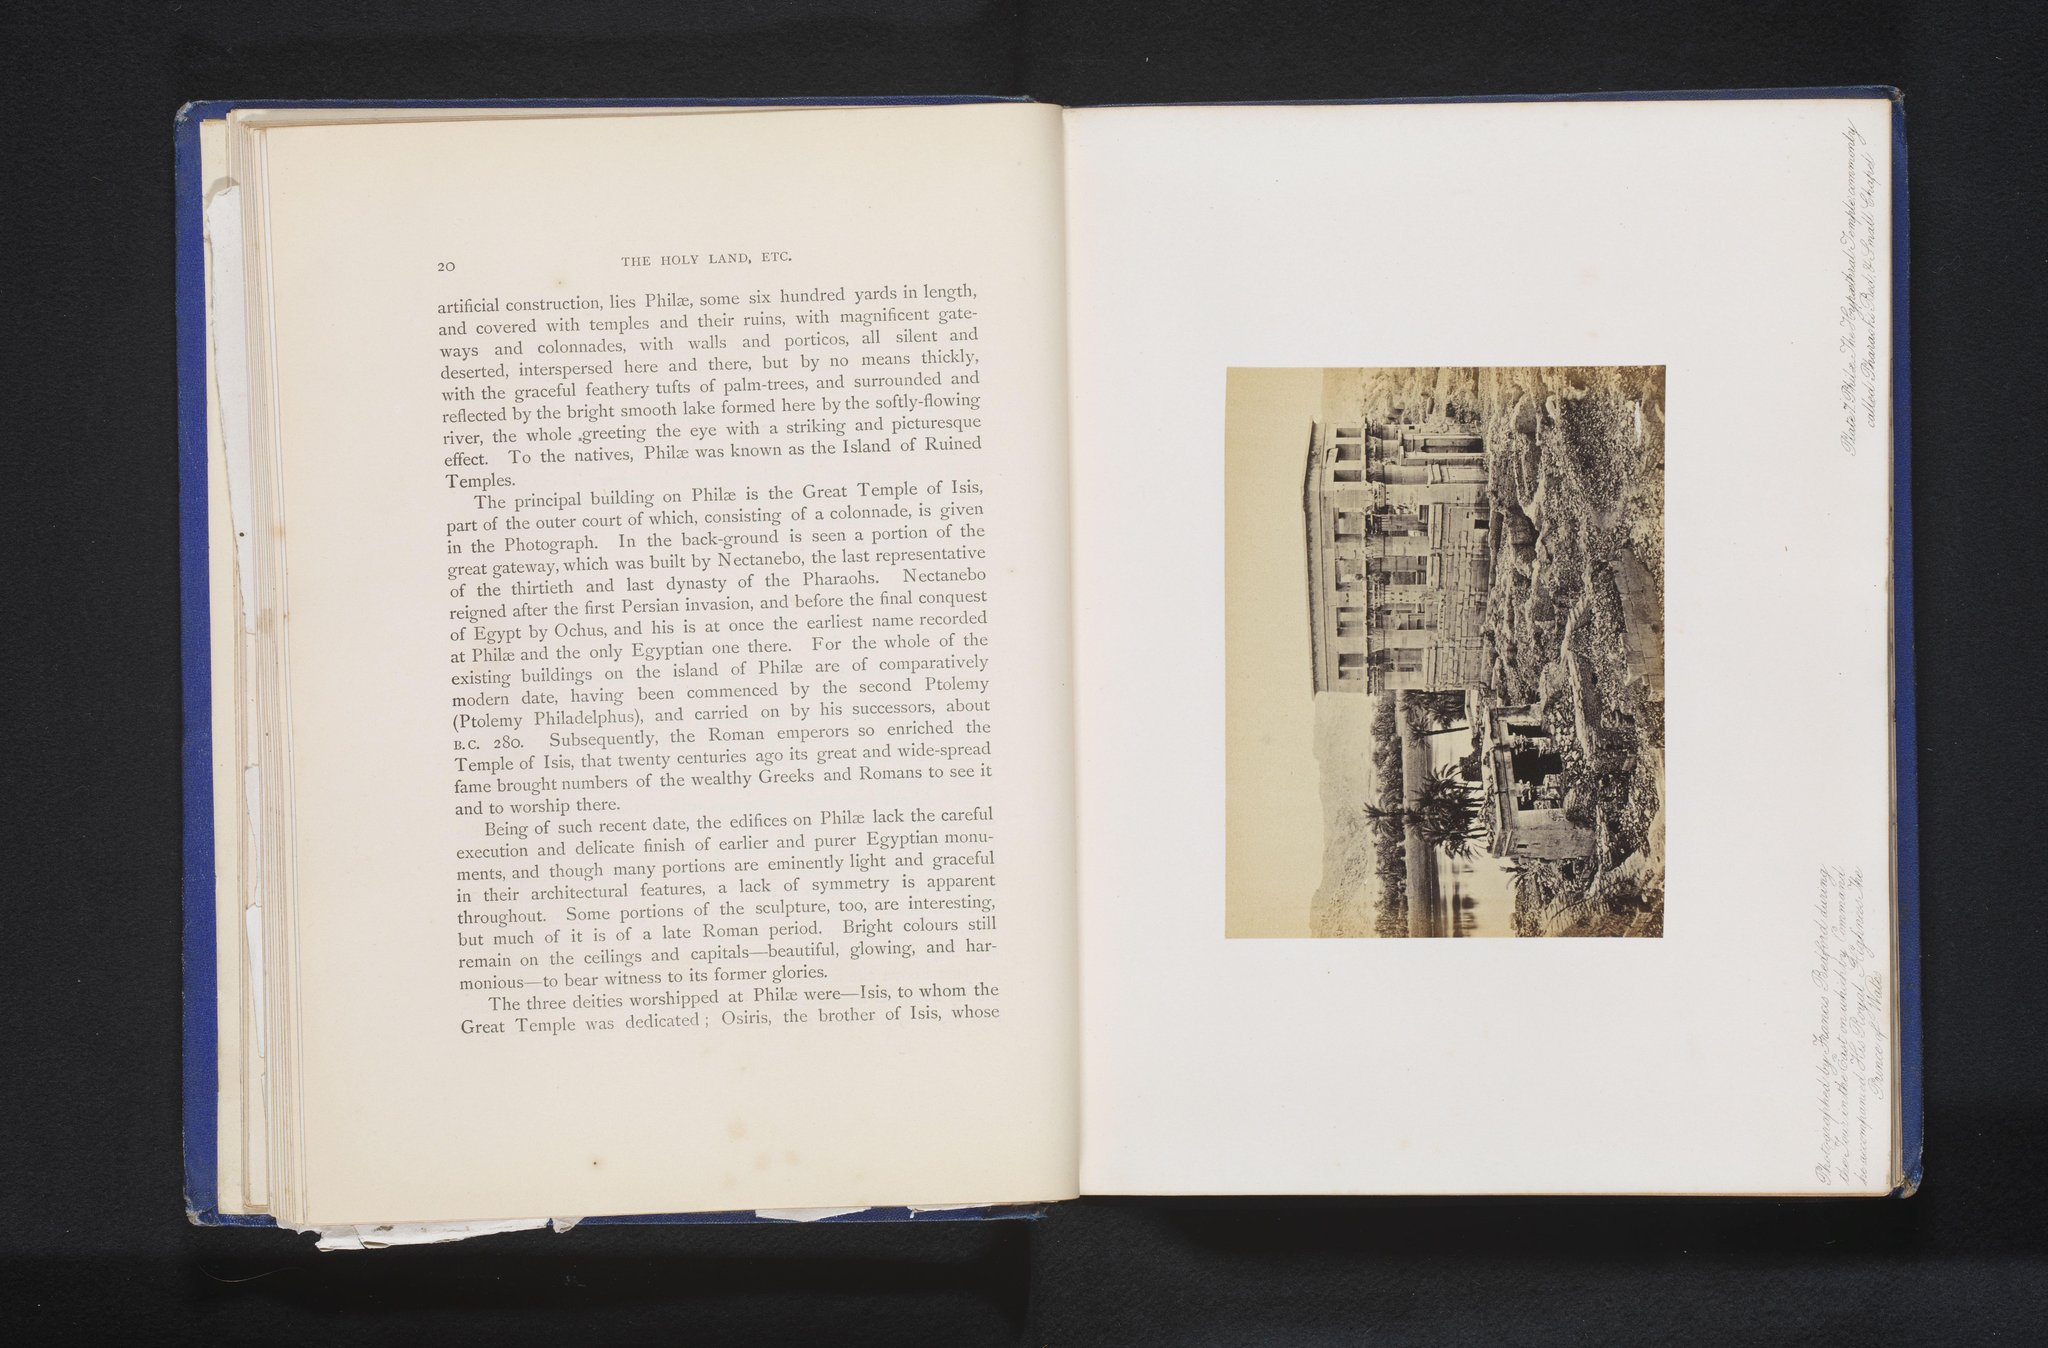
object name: page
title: Philae-The Hypaethral Temple commonly called Pharaoh's Bed & Small Chapel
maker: francis bedford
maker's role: print maker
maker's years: 1815-1894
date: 1861-1866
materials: photographic support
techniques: albumen print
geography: philae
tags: temple, shrine ~ egyptian religion, façade (of house or building)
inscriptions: number: ‘Plate 7.’, inscription: ‘Photographed by Francis Bedford during the Tour in the East on which by Command he accompanied His Royal Highness The Prince of Wales’